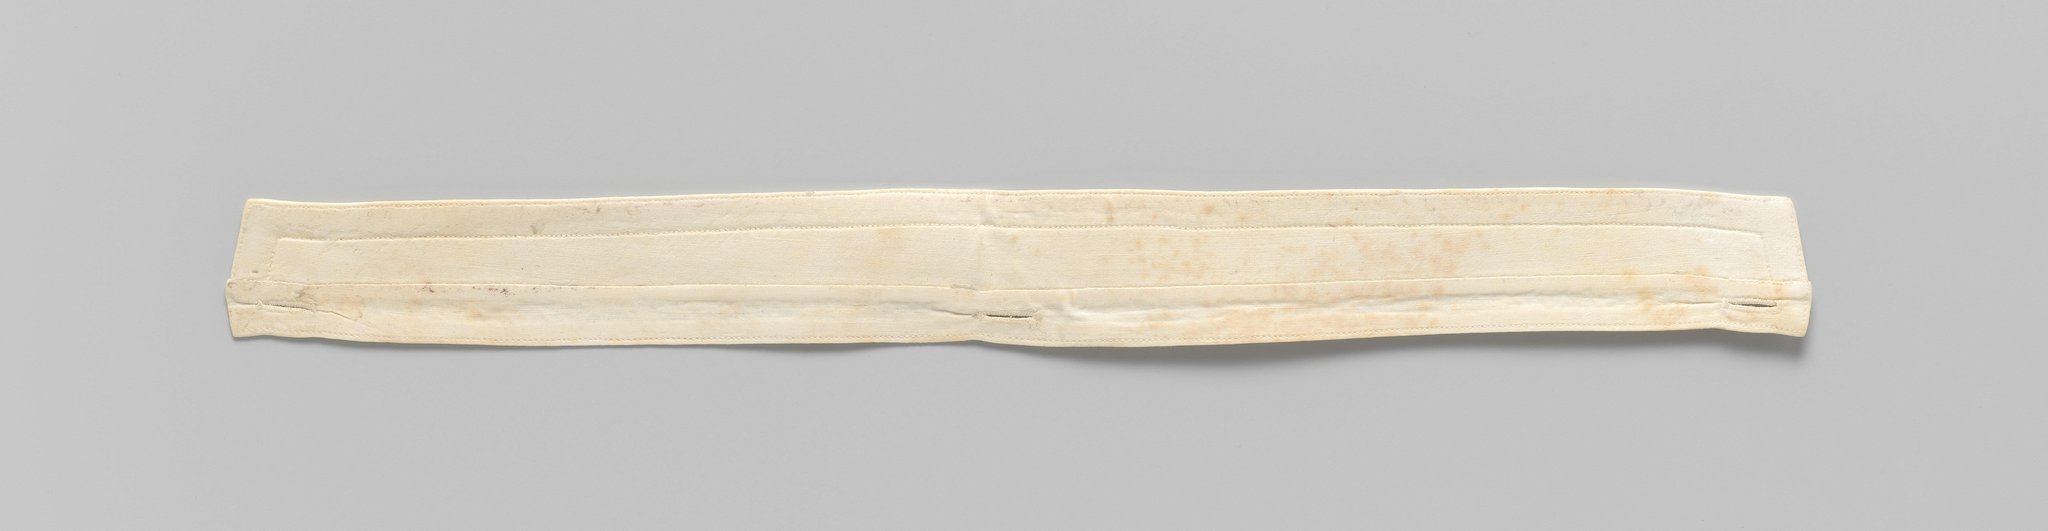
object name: collar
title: Vadermoordenaar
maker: Anonymous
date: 1850-1920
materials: cotton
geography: europe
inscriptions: label: ‘RBK 1982-80’, name: ‘EGLINTON 14’